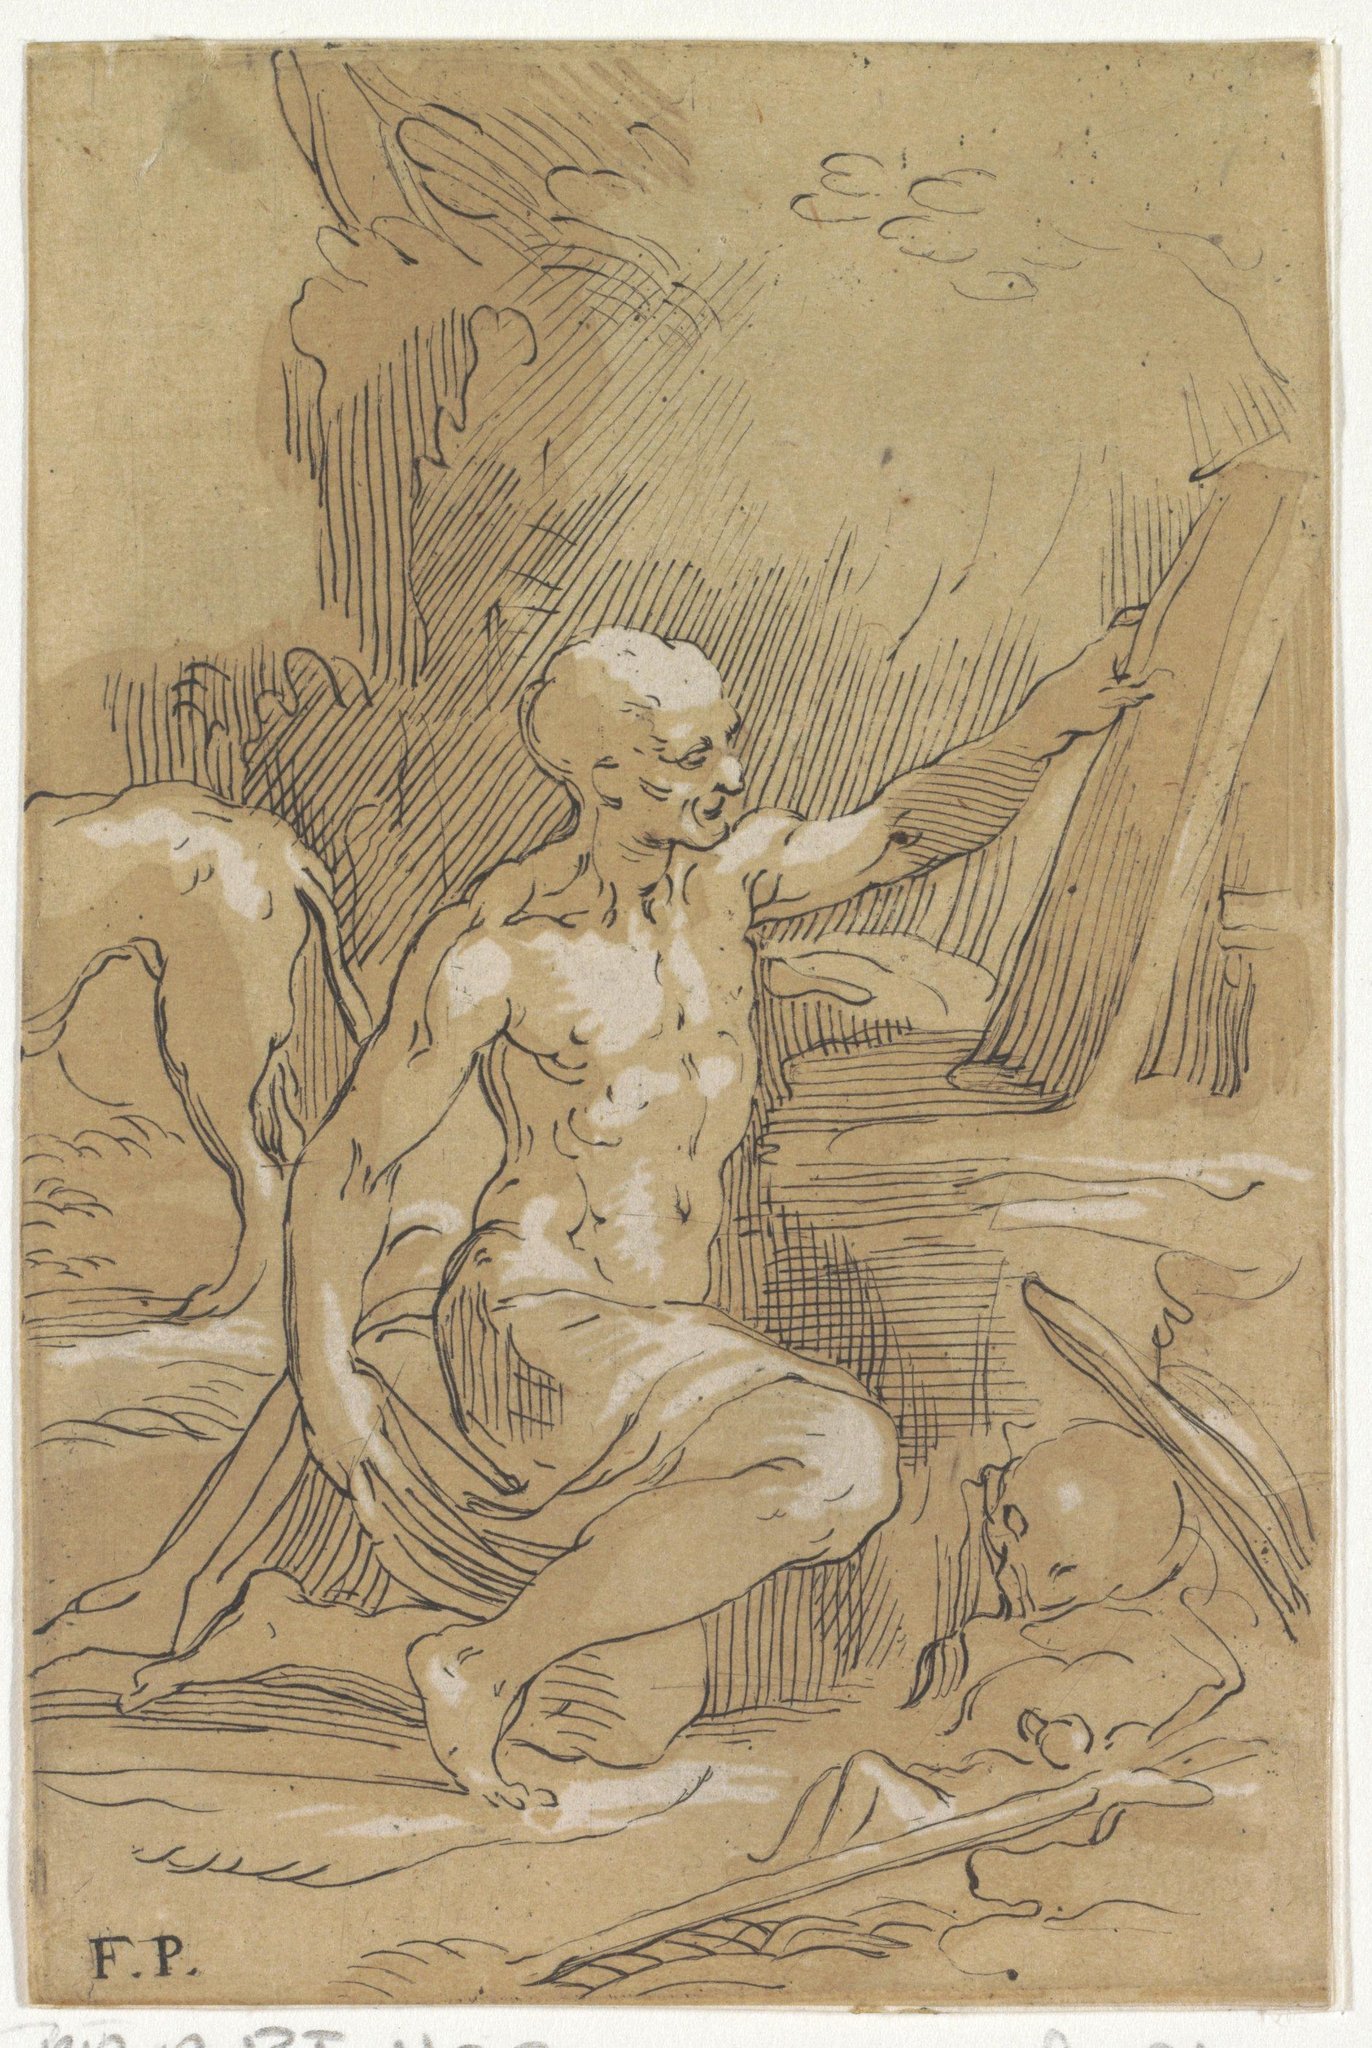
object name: print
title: Studieblad met een knielende oude man te midden van puin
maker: monogrammist fp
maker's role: print maker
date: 1640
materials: paper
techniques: woodcut, etching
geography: northern netherlands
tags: old man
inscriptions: collector's mark: Lugt 240